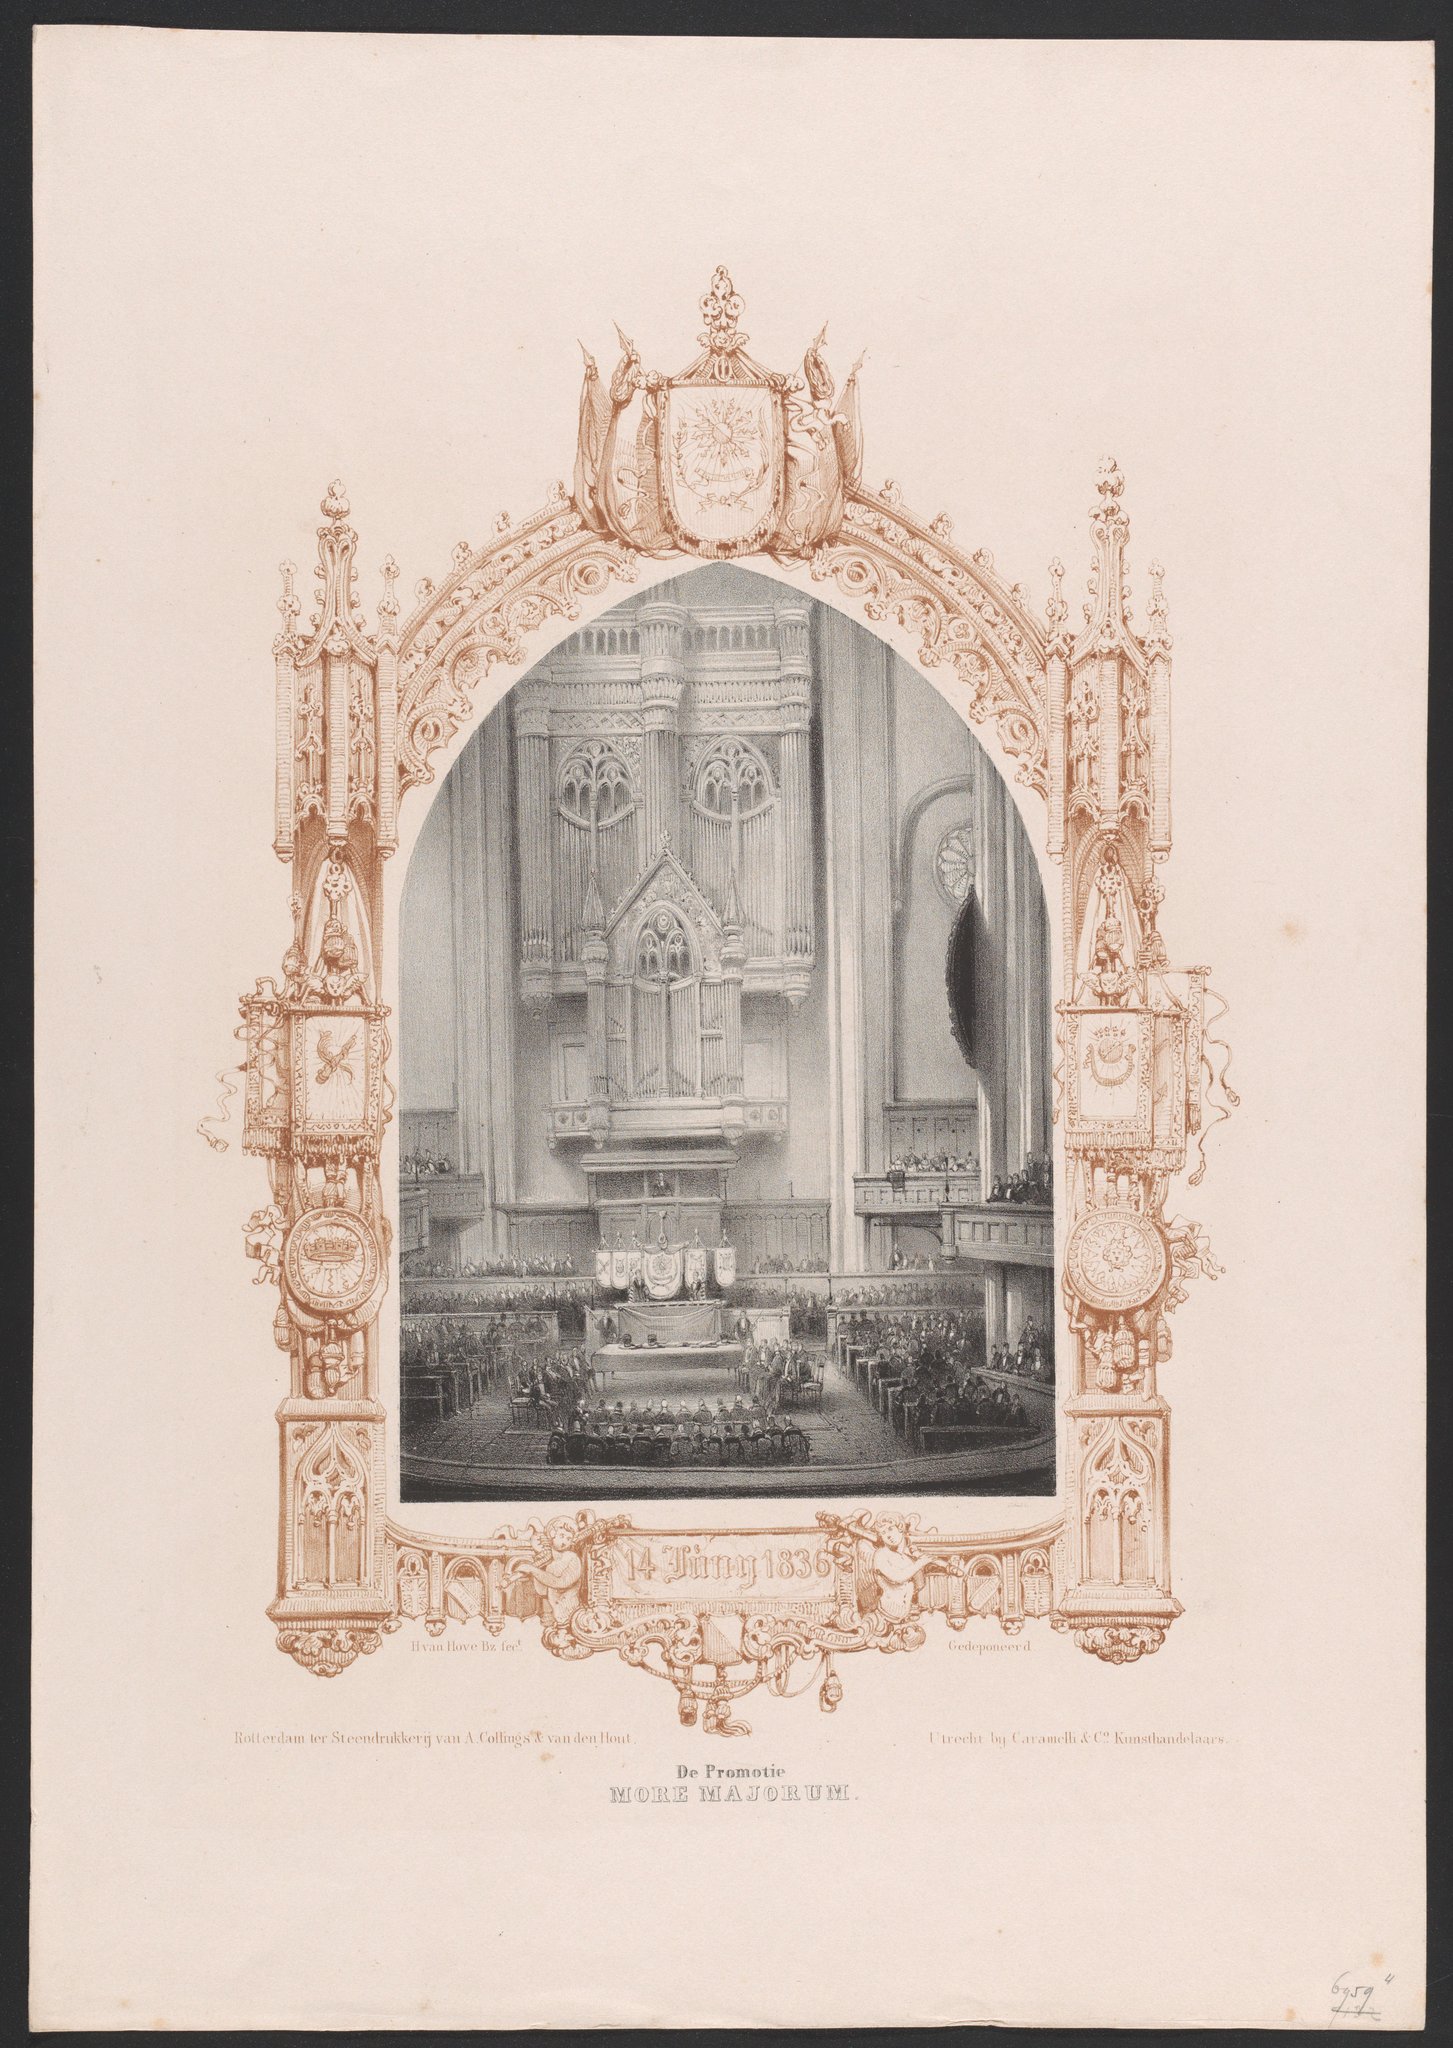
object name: print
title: Platen van de viering van het tweede eeuwfeest van de Utrechtsche Hogeschool, 1836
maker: huib van hove bz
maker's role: painter, print maker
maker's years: 1814-1867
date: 1836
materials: paper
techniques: lithograph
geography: utrecht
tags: receiving doctor's degree, interior of church, commemoration of the founding of a university, utrecht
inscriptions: : ‘Gedeponeerd’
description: Gezicht in het interieur van de Domkerk waar een promotie 'more majorum', een publieke promotie, plaatsvindt, 14 juni 1836. Binnen een gekleurde decoratieve kader met kerkelijke ornamenten. Onderdeel van de serie van zes ongenummerde platen van de feestelijkheden bij de viering van het tweede eeuwfeest (1636-1836) van de Utrechtsche Hogeschool, 12-17 juni 1836.